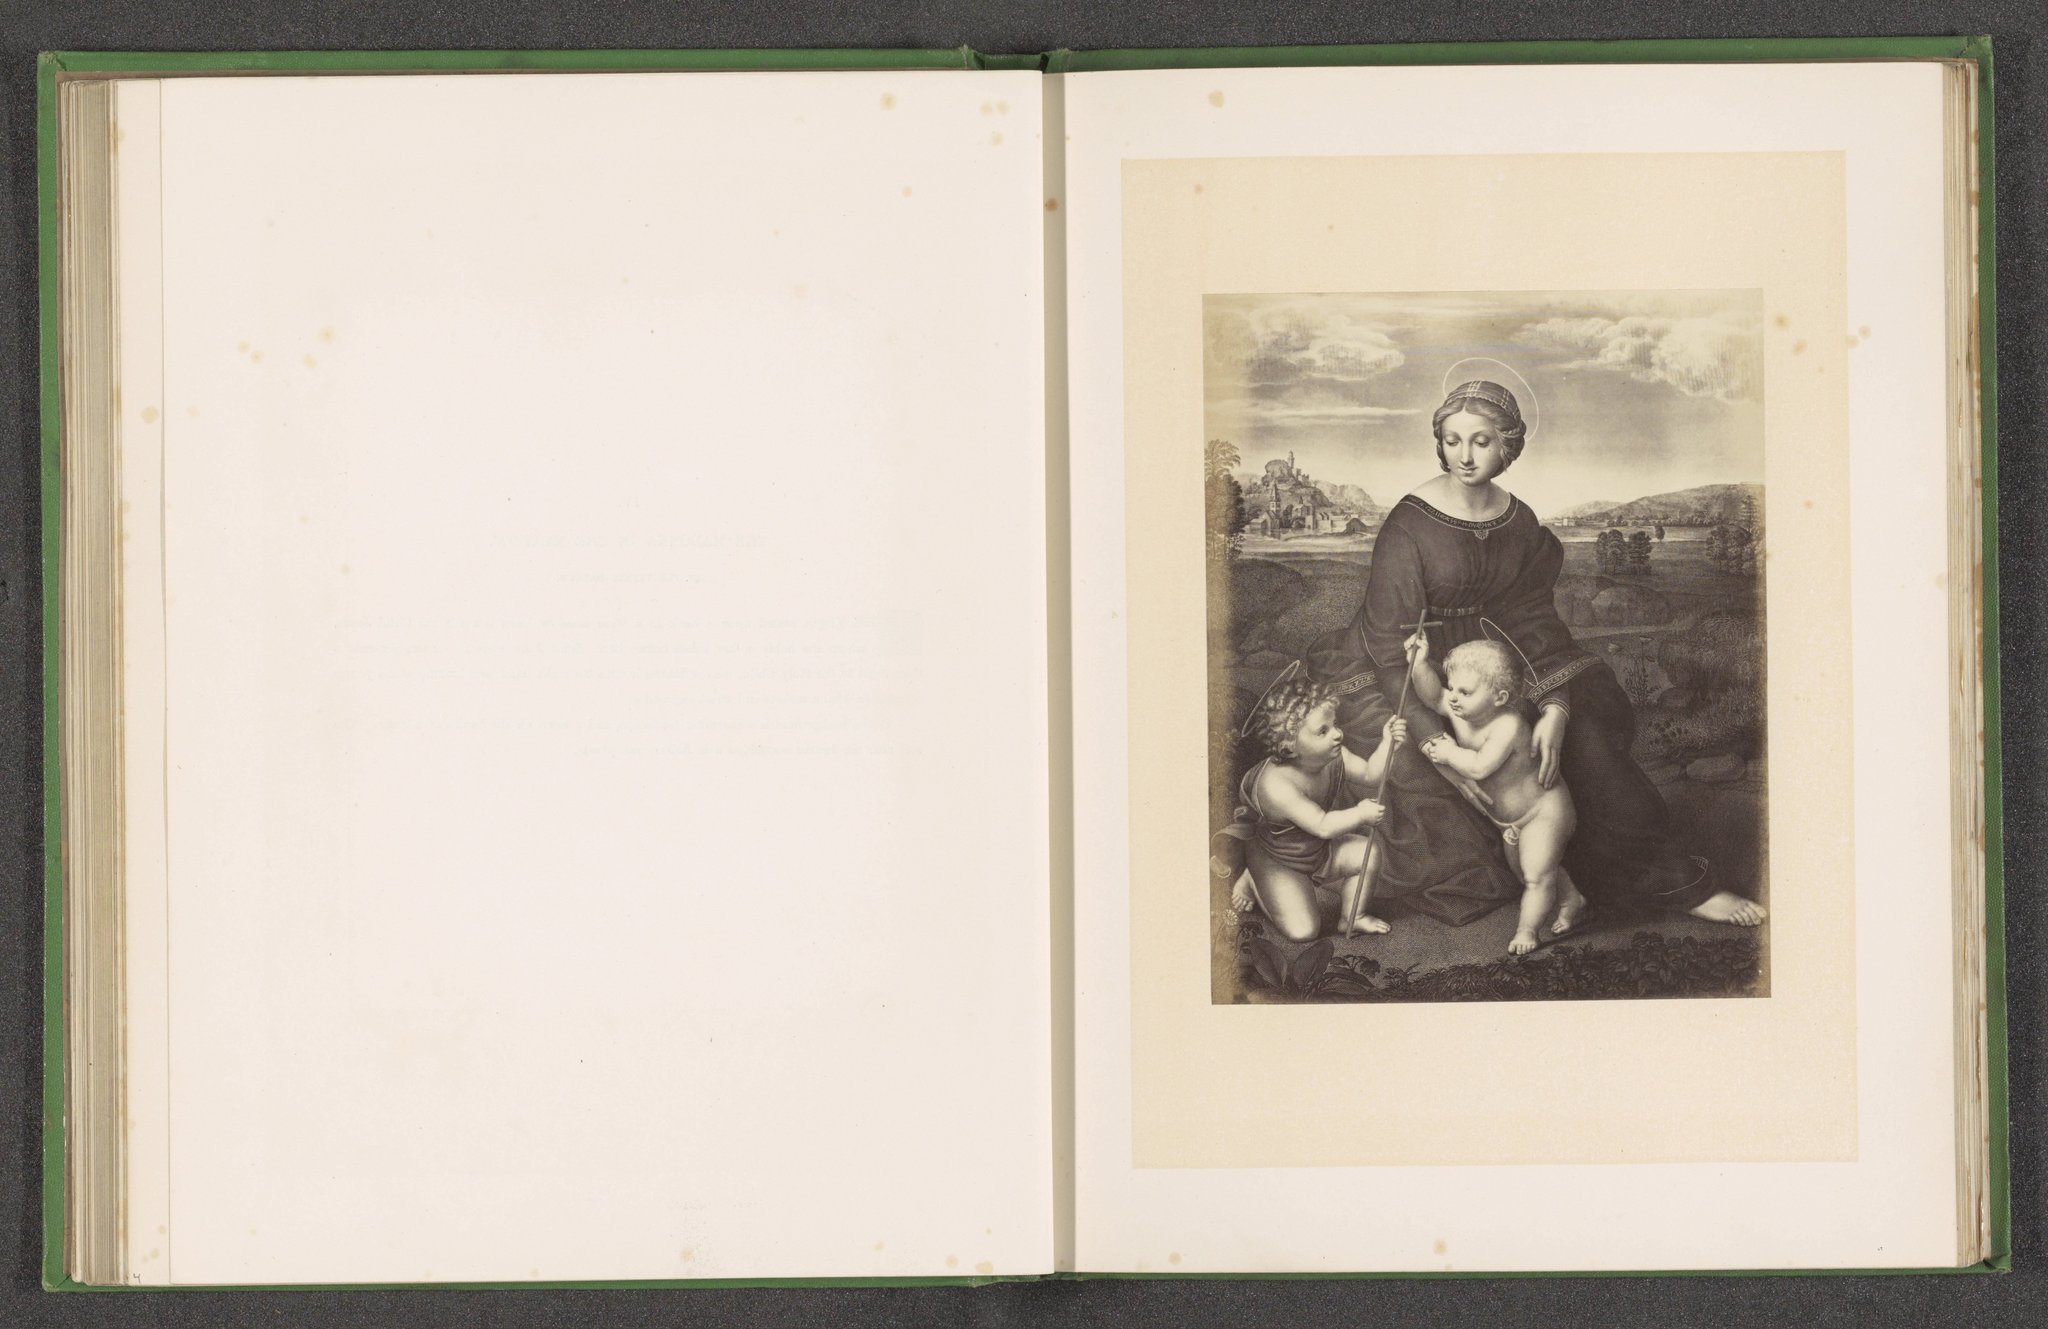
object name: page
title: Fotoreproductie van een prent door Joseph Steinmueller van de Madonna del Prato door Rafaël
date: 1859-1869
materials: photographic support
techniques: albumen print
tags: madonna: i.e. mary with the christ-child